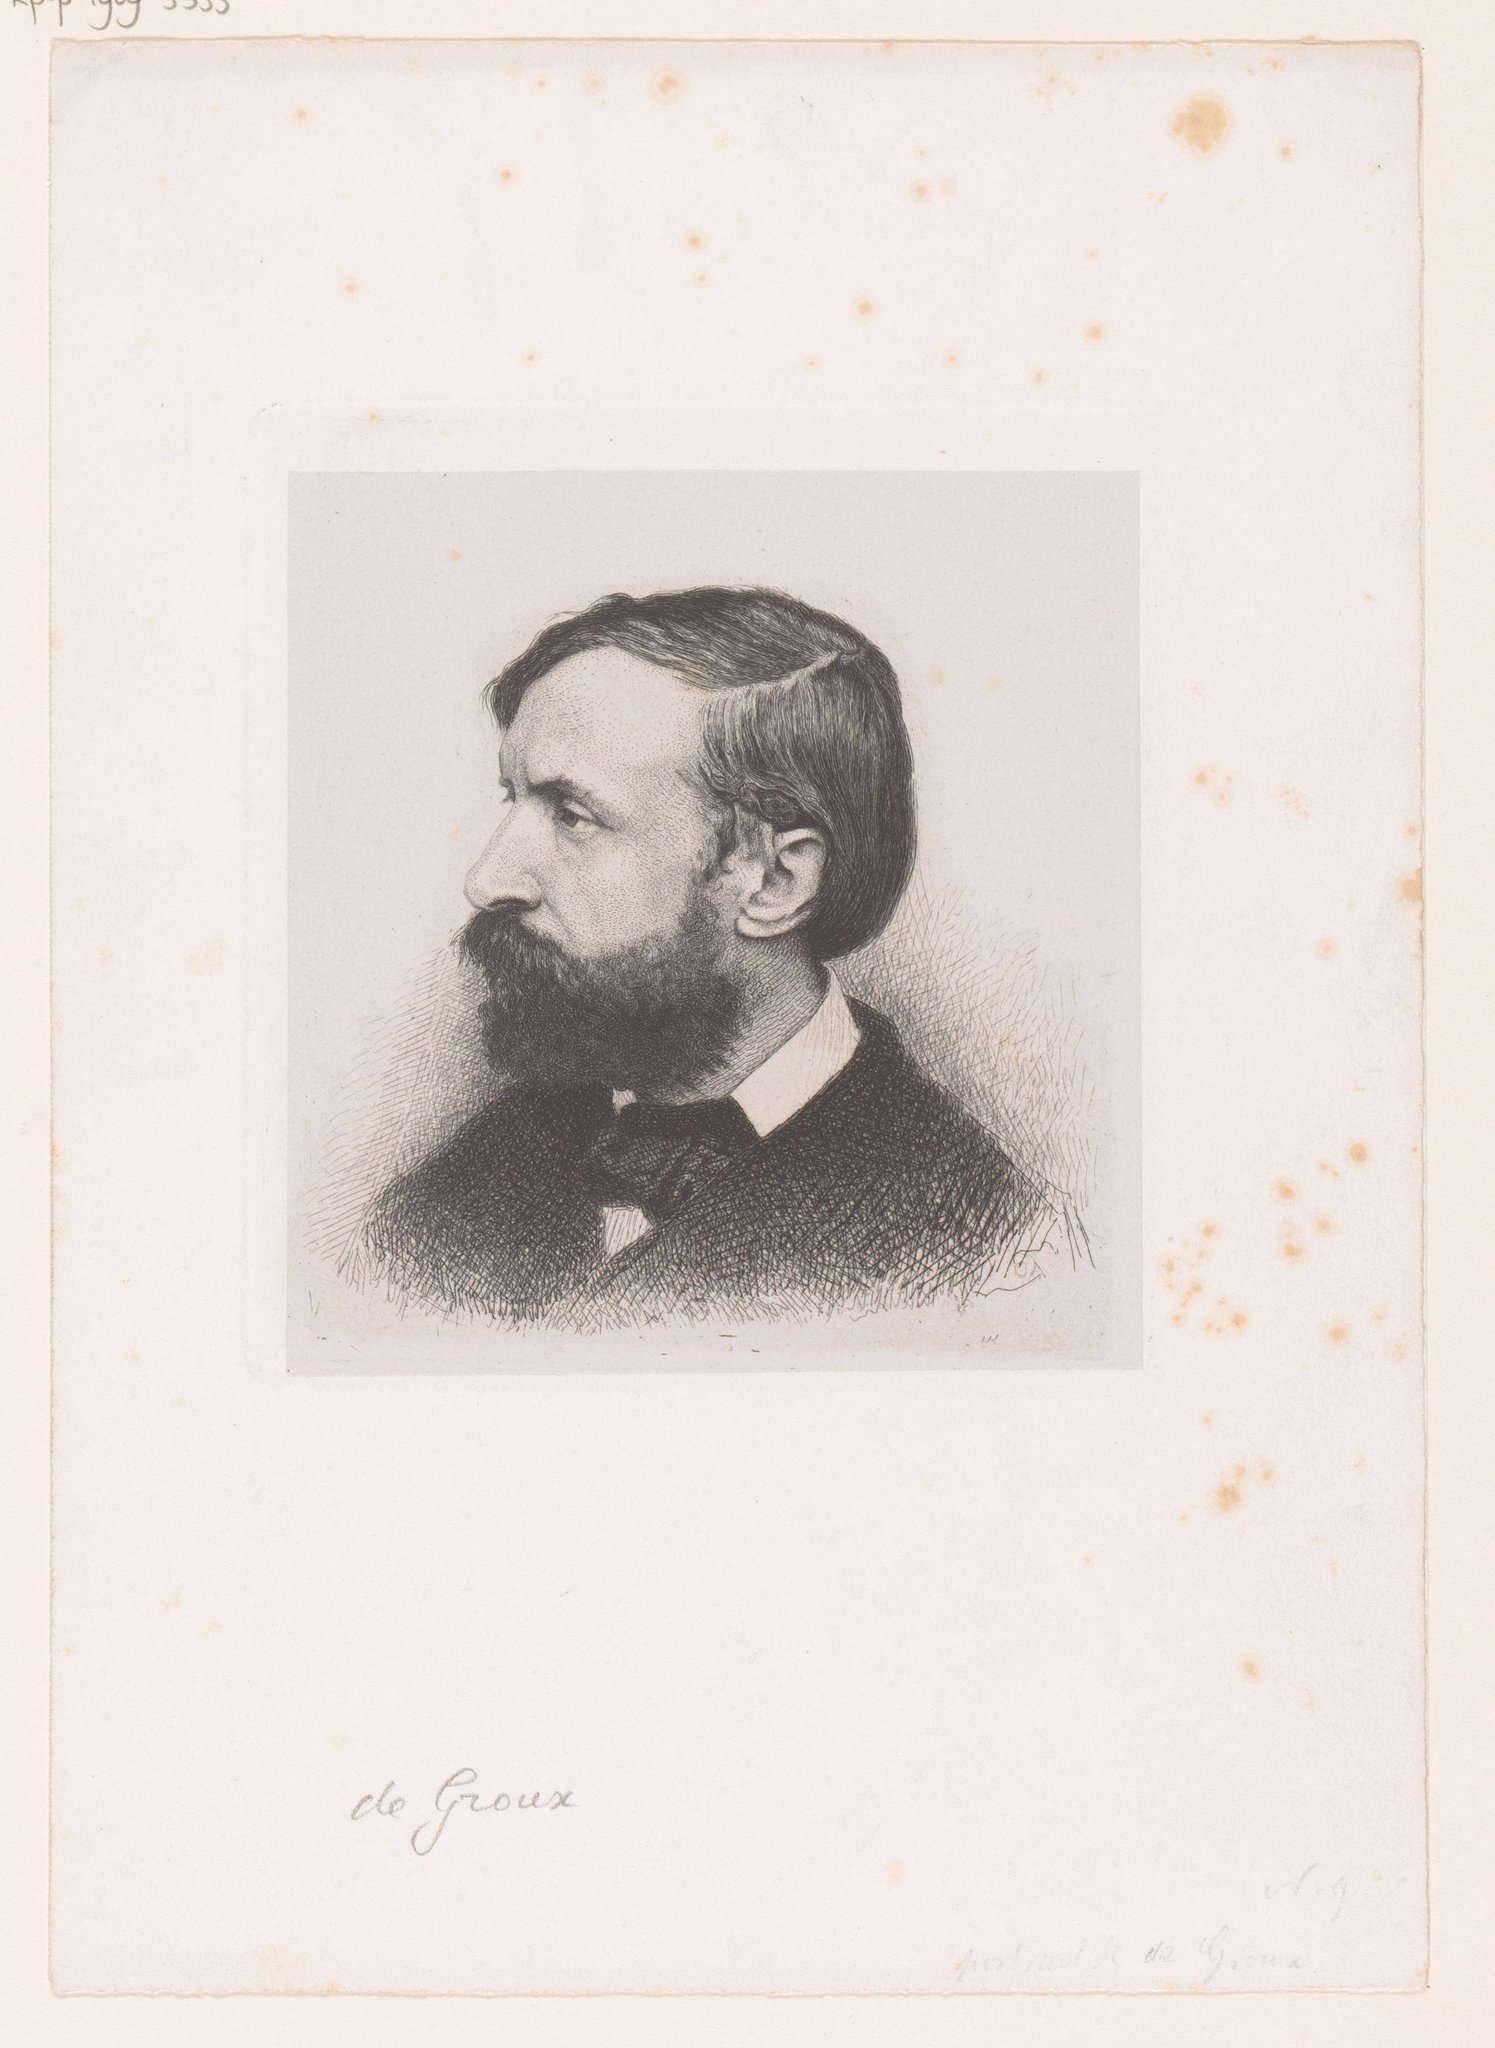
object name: print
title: Portret van Charles de Groux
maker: auguste danse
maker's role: print maker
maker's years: 1829-1929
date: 1886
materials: paper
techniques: etching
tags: painter, charles de groux, portrait, self-portrait of painter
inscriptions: collector's mark: Lugt 2228